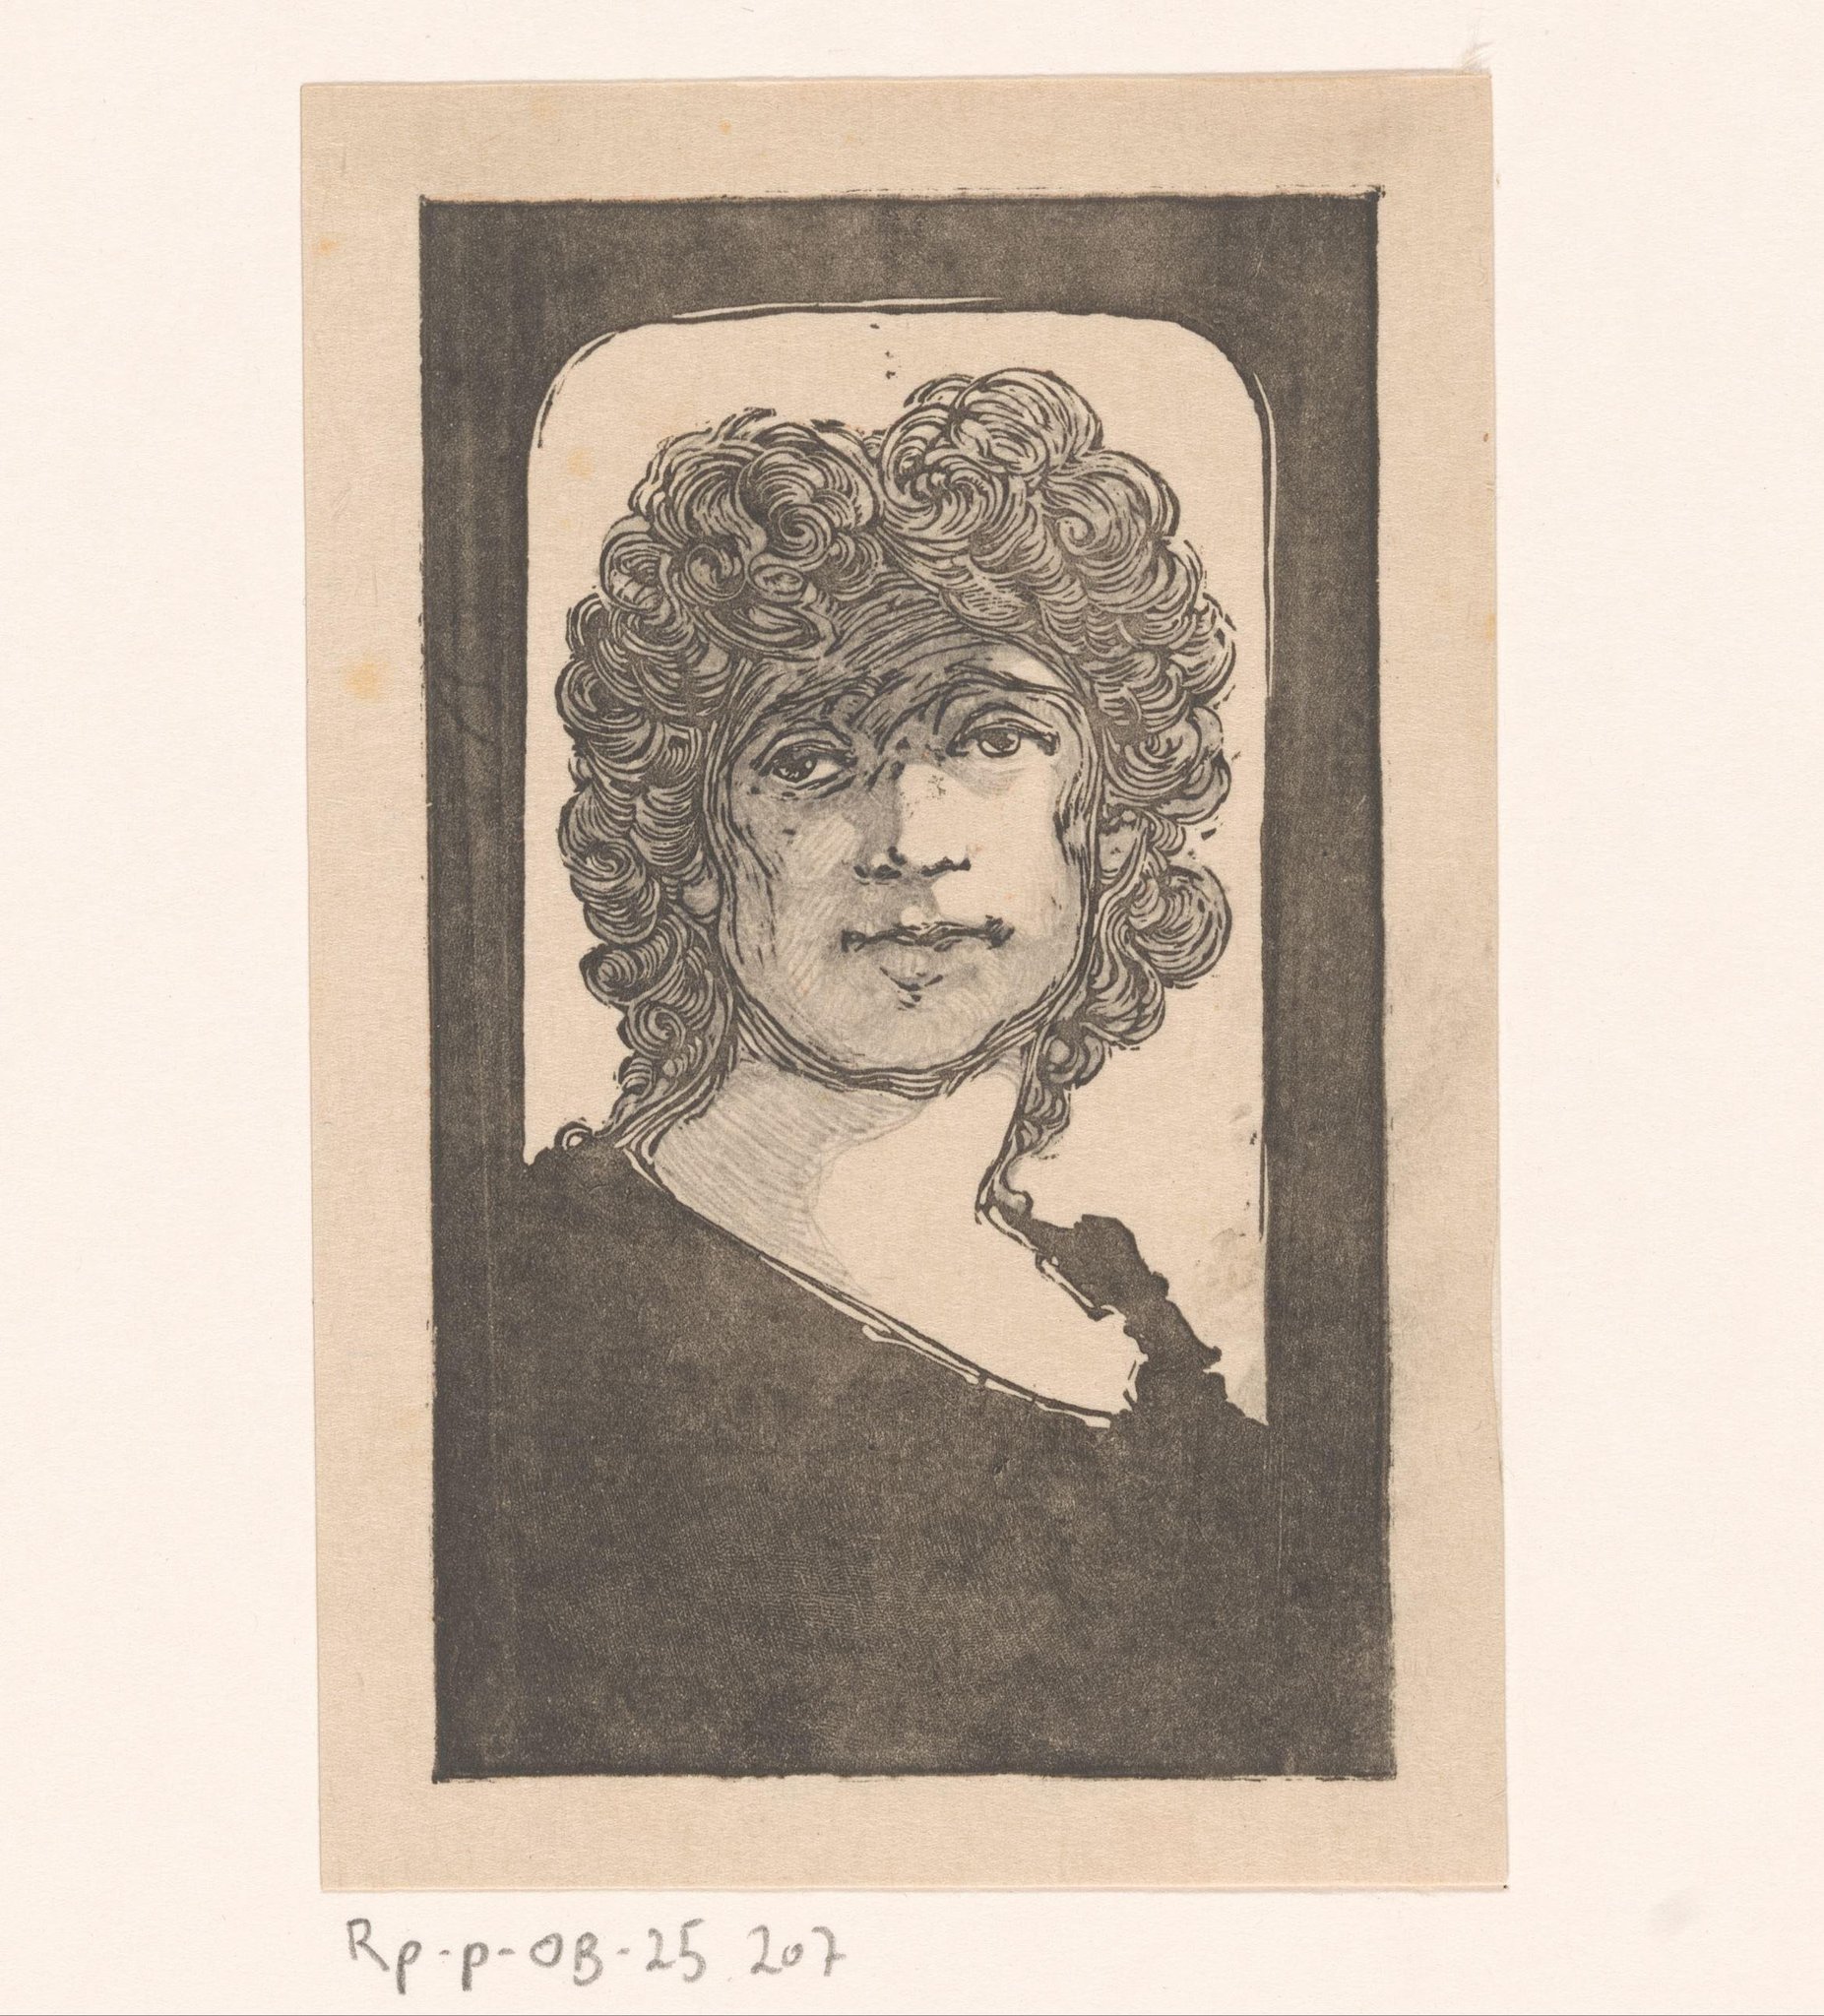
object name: print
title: Portret van een vrouw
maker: bernard willem wierink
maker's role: draughtsman, print maker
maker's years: 1856-1939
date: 1866-1939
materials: paper, pencil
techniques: relief print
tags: anonymous historical person portrayed - bb - woman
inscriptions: collector's mark: Lugt 2228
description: Deze prent is vermoedelijk een plaatsnede, ook al wordt in de literatuur veelal gesproken over een houtsnede. Voor zover Wierink zijn prenten in hoogdruk zelf nader heeft omschreven, heeft hij altijd de term 'plaatsnede' gebruikt.